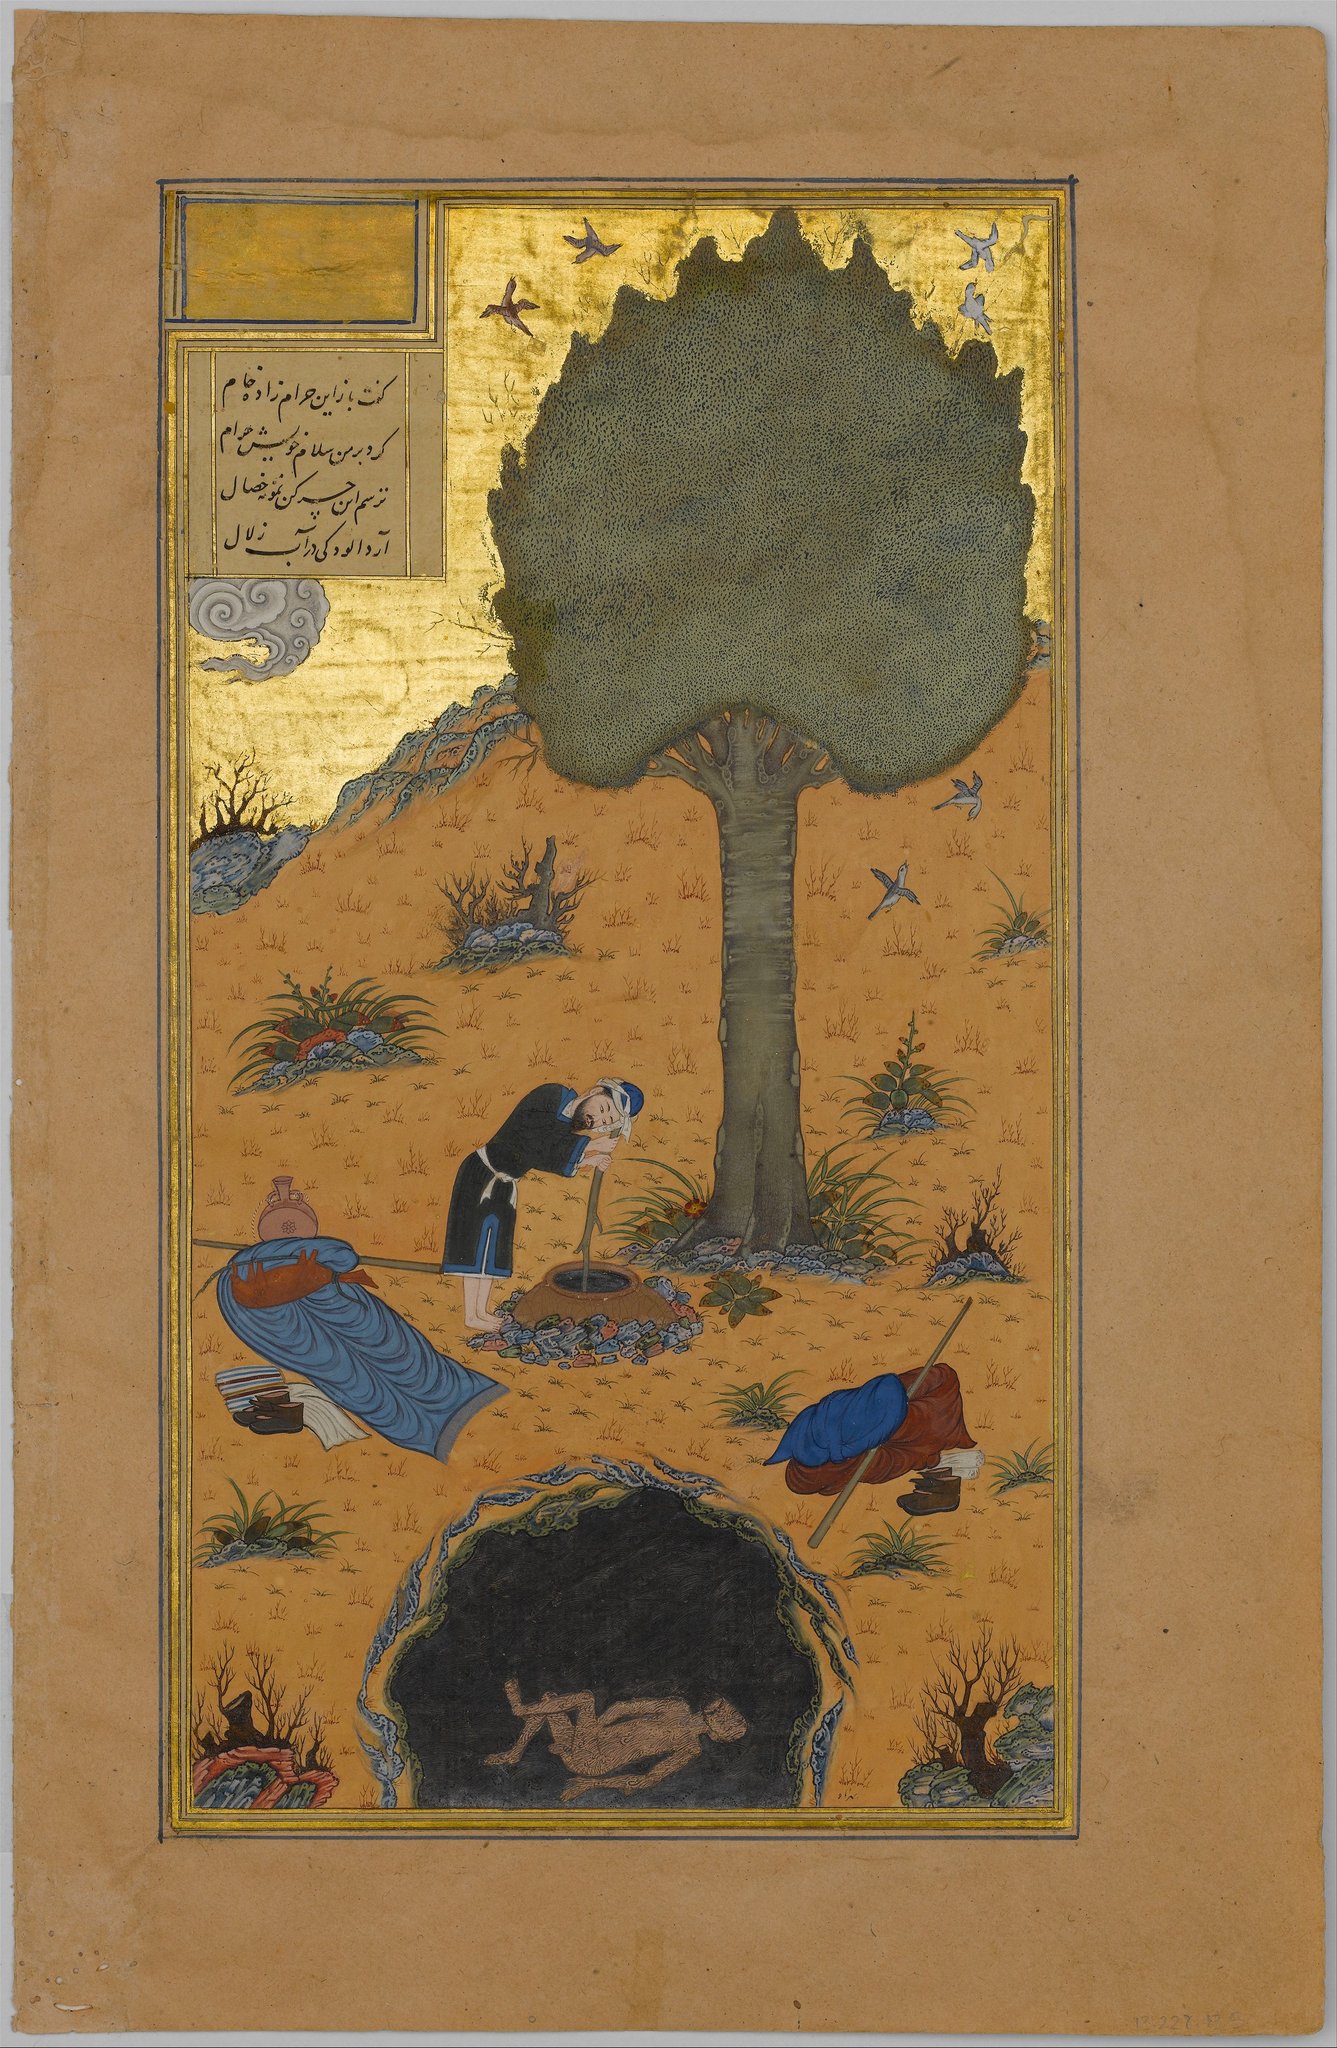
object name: folio from an illustrated manuscript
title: "How a Braggart was Drowned in a Well", Folio 33v from a Haft Paikar (Seven Portraits) of the Khamsa (Quintet) of Nizami of Ganja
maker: nizami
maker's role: author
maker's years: 1141-1209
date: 1430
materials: gold, ink, paper, watercolor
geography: afghanistan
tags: wells,men,deserts,trees